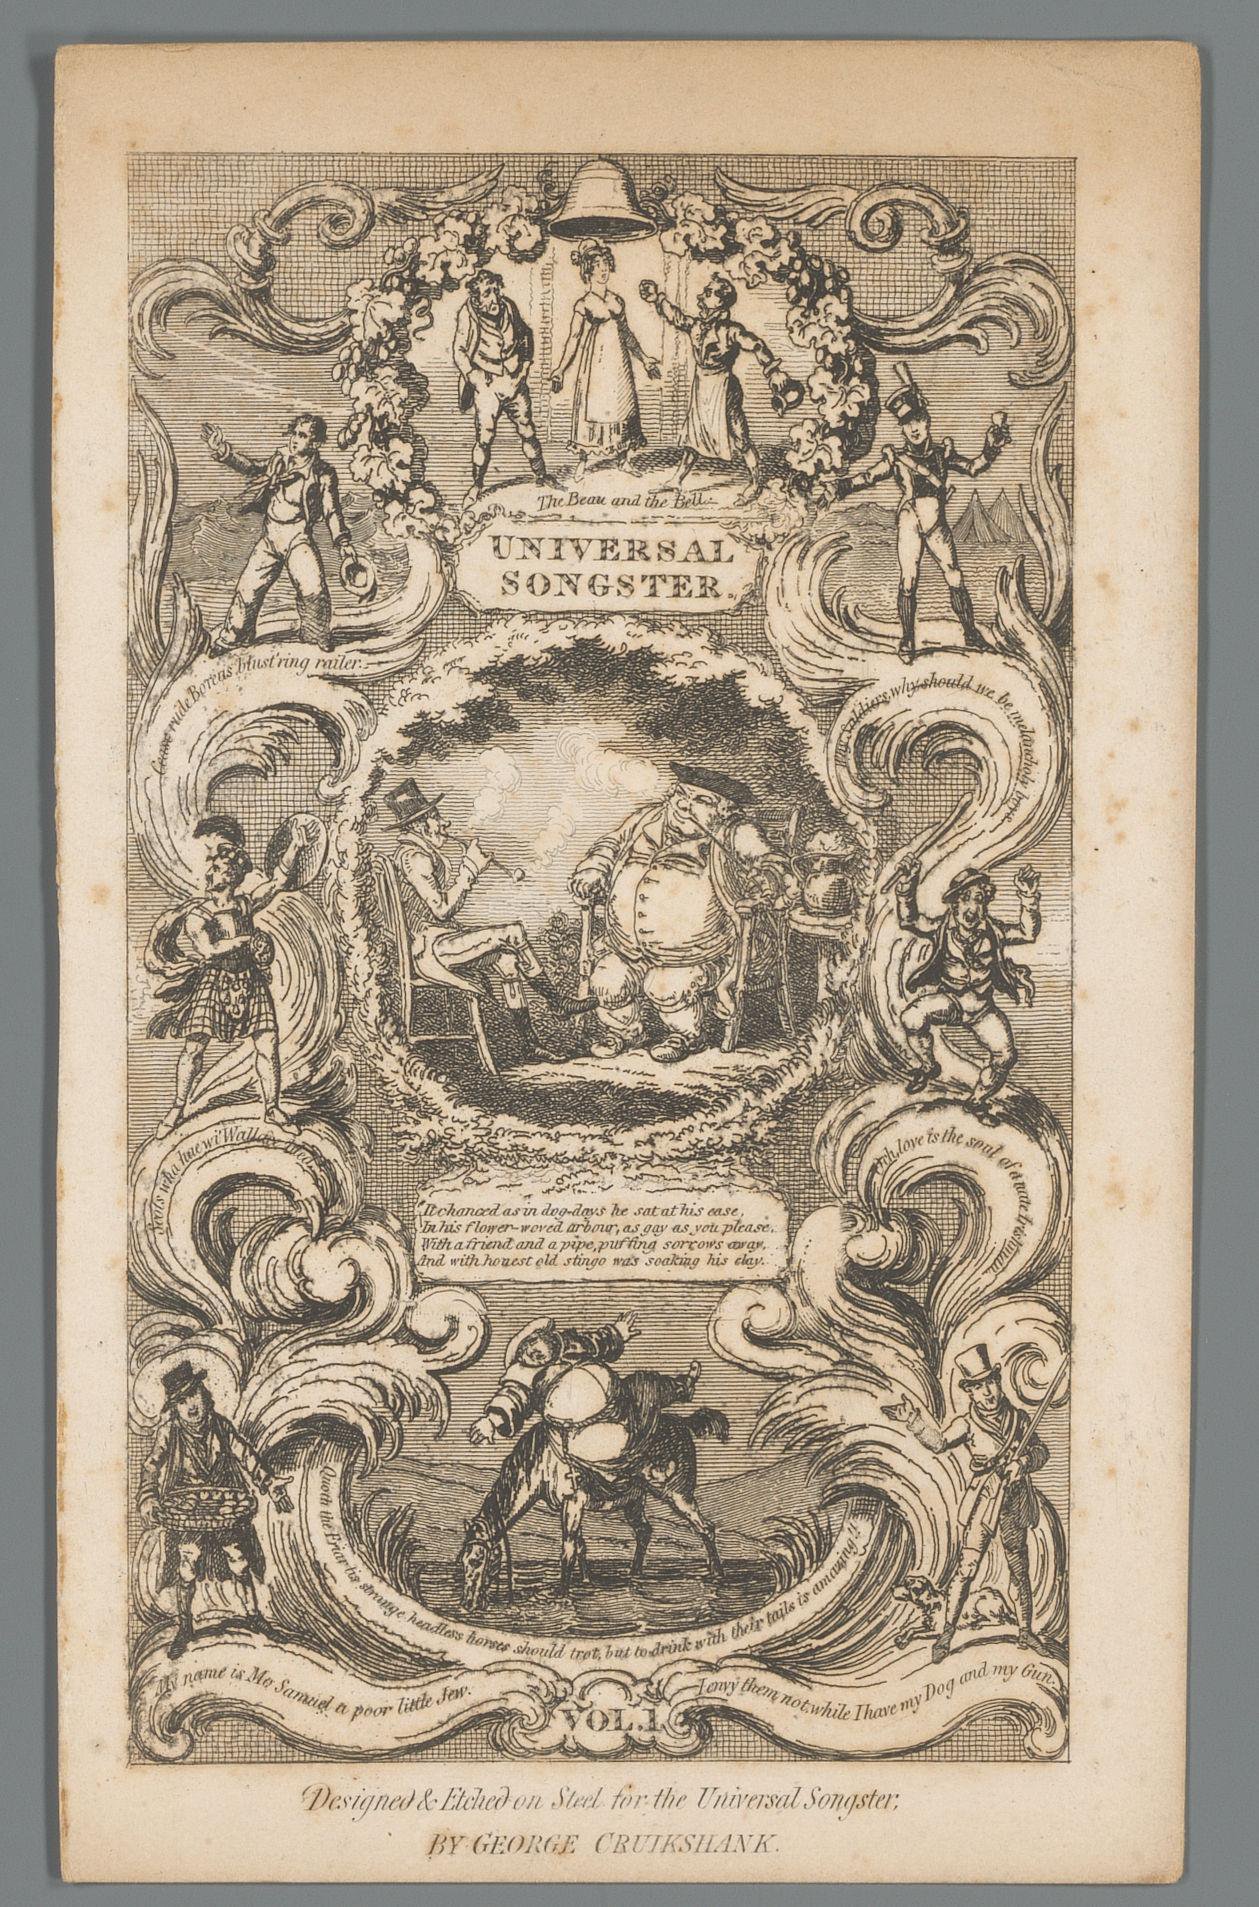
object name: print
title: Frontispice voor: The Universal Songster, vol. I (1825)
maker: george cruikshank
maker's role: painter, print maker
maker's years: 1792-1878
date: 1825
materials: paper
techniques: etching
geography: london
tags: political caricatures and satires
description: Illustratie genomen uit een uitgave van: The Universal Songster, or Museum of Mirth: the most complete, extensive and valuable collection of ancient and modern songs in the English language, vol. I., Jones & Co: Londen, eerst verschenen in 1825.